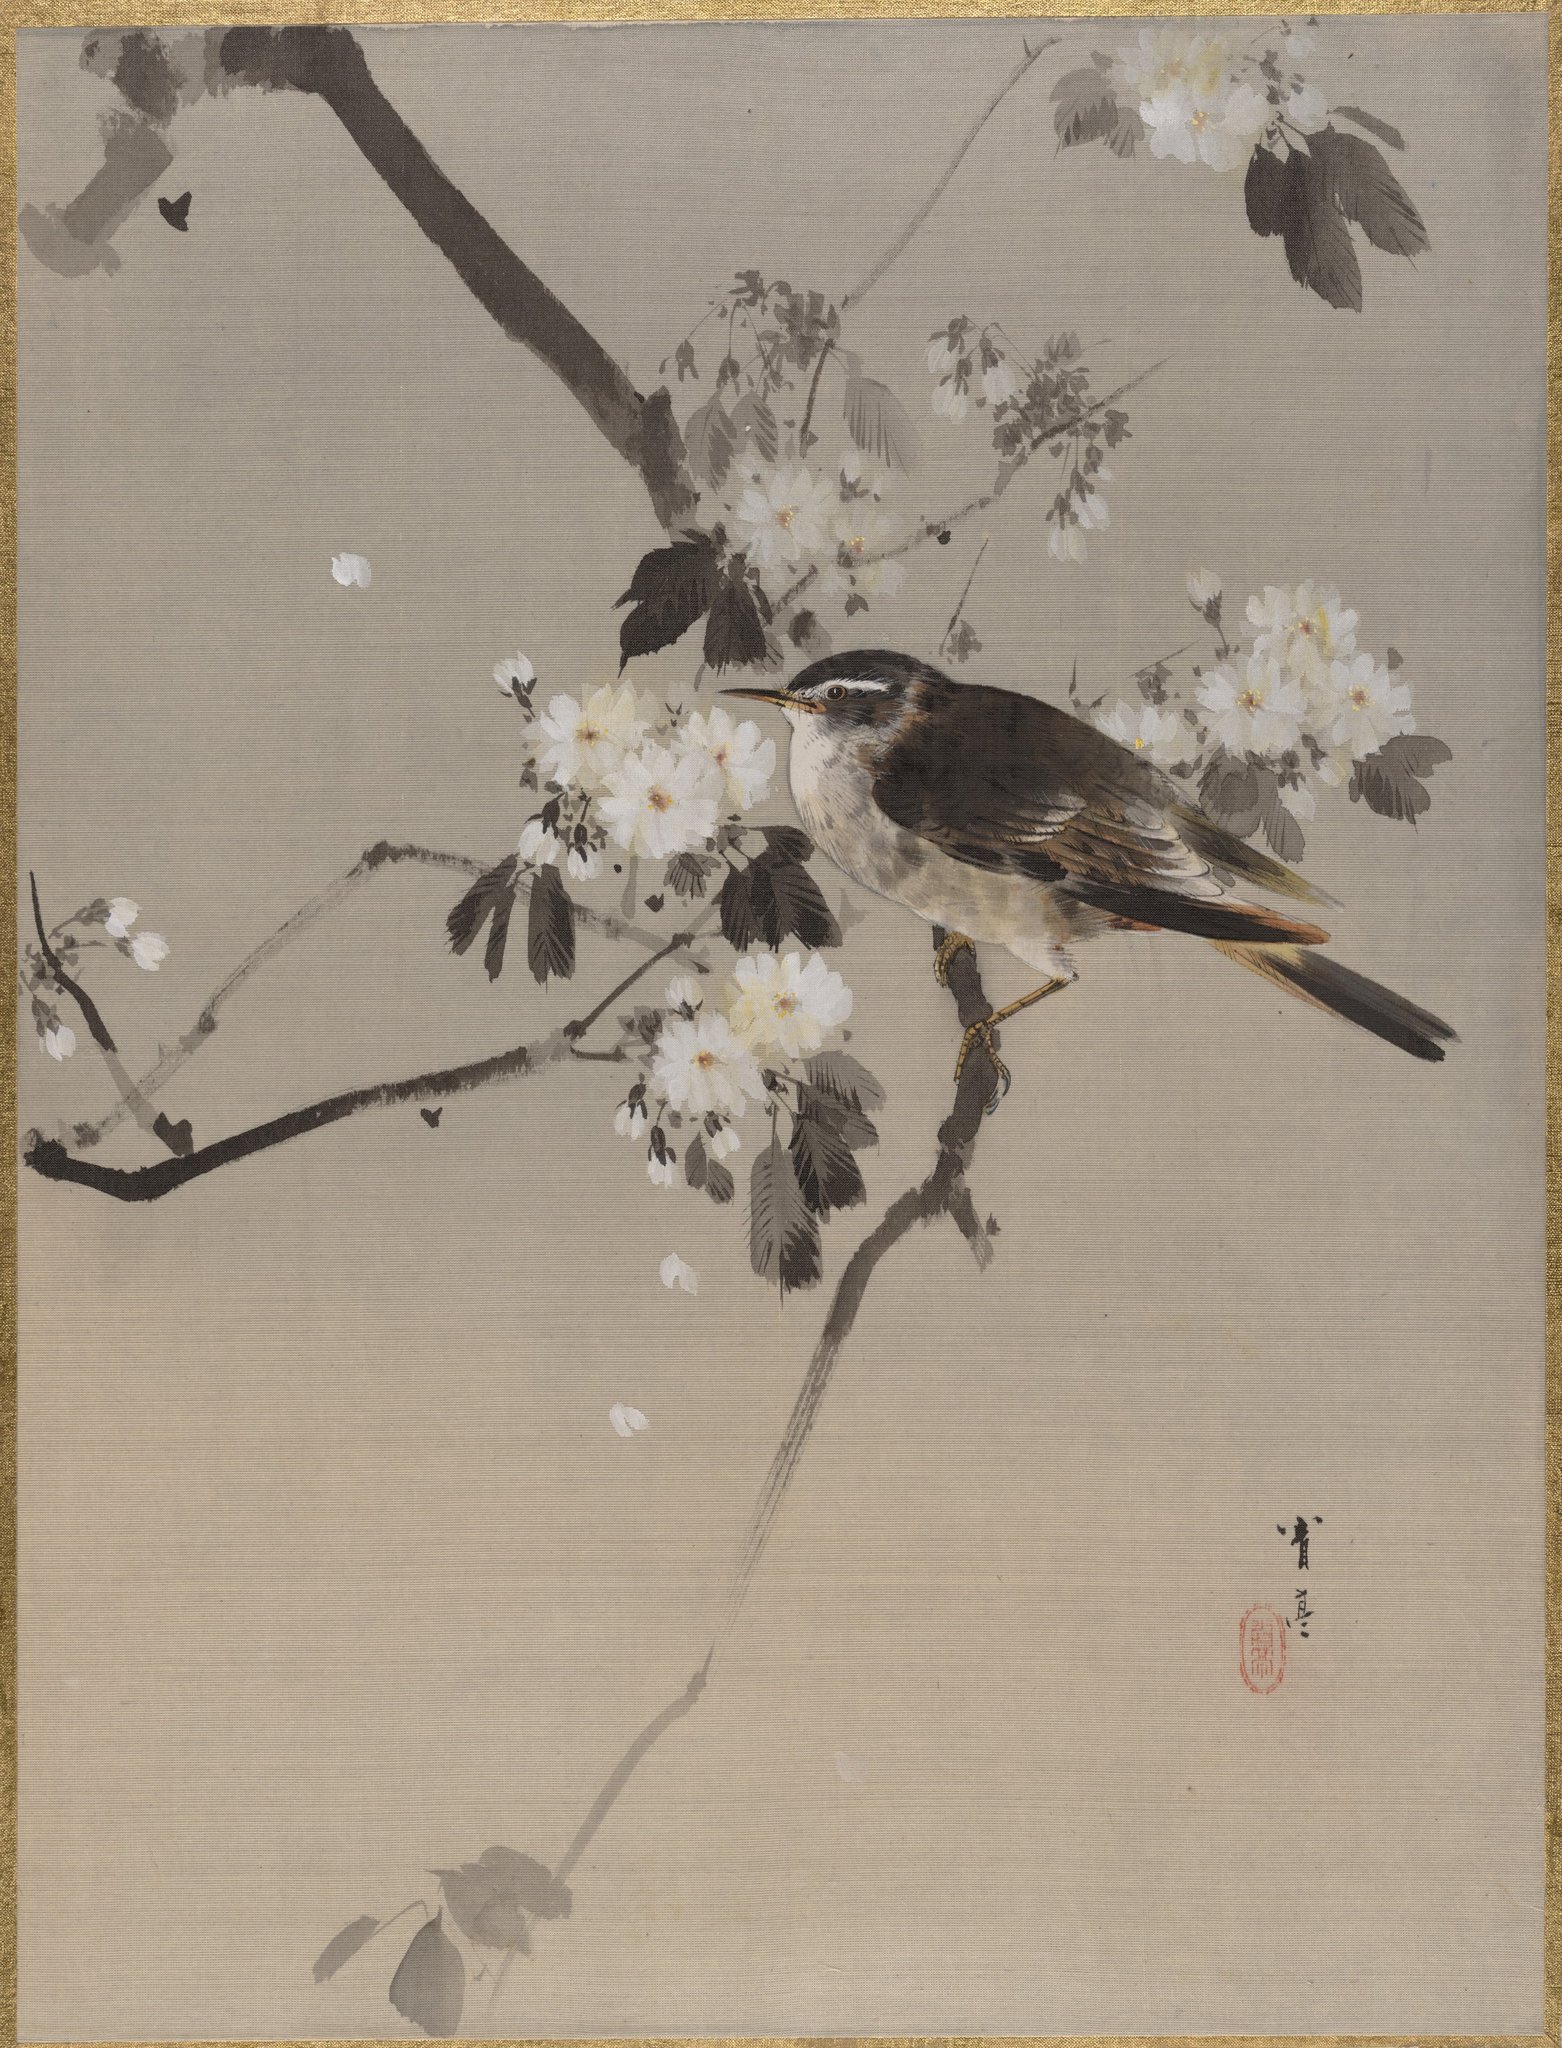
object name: album leaf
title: Birds on a Flowering Branch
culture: japanese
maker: watanabe seitei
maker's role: artist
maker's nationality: japanese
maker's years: 1851-1918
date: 1887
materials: ink, silk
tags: birds,flowers